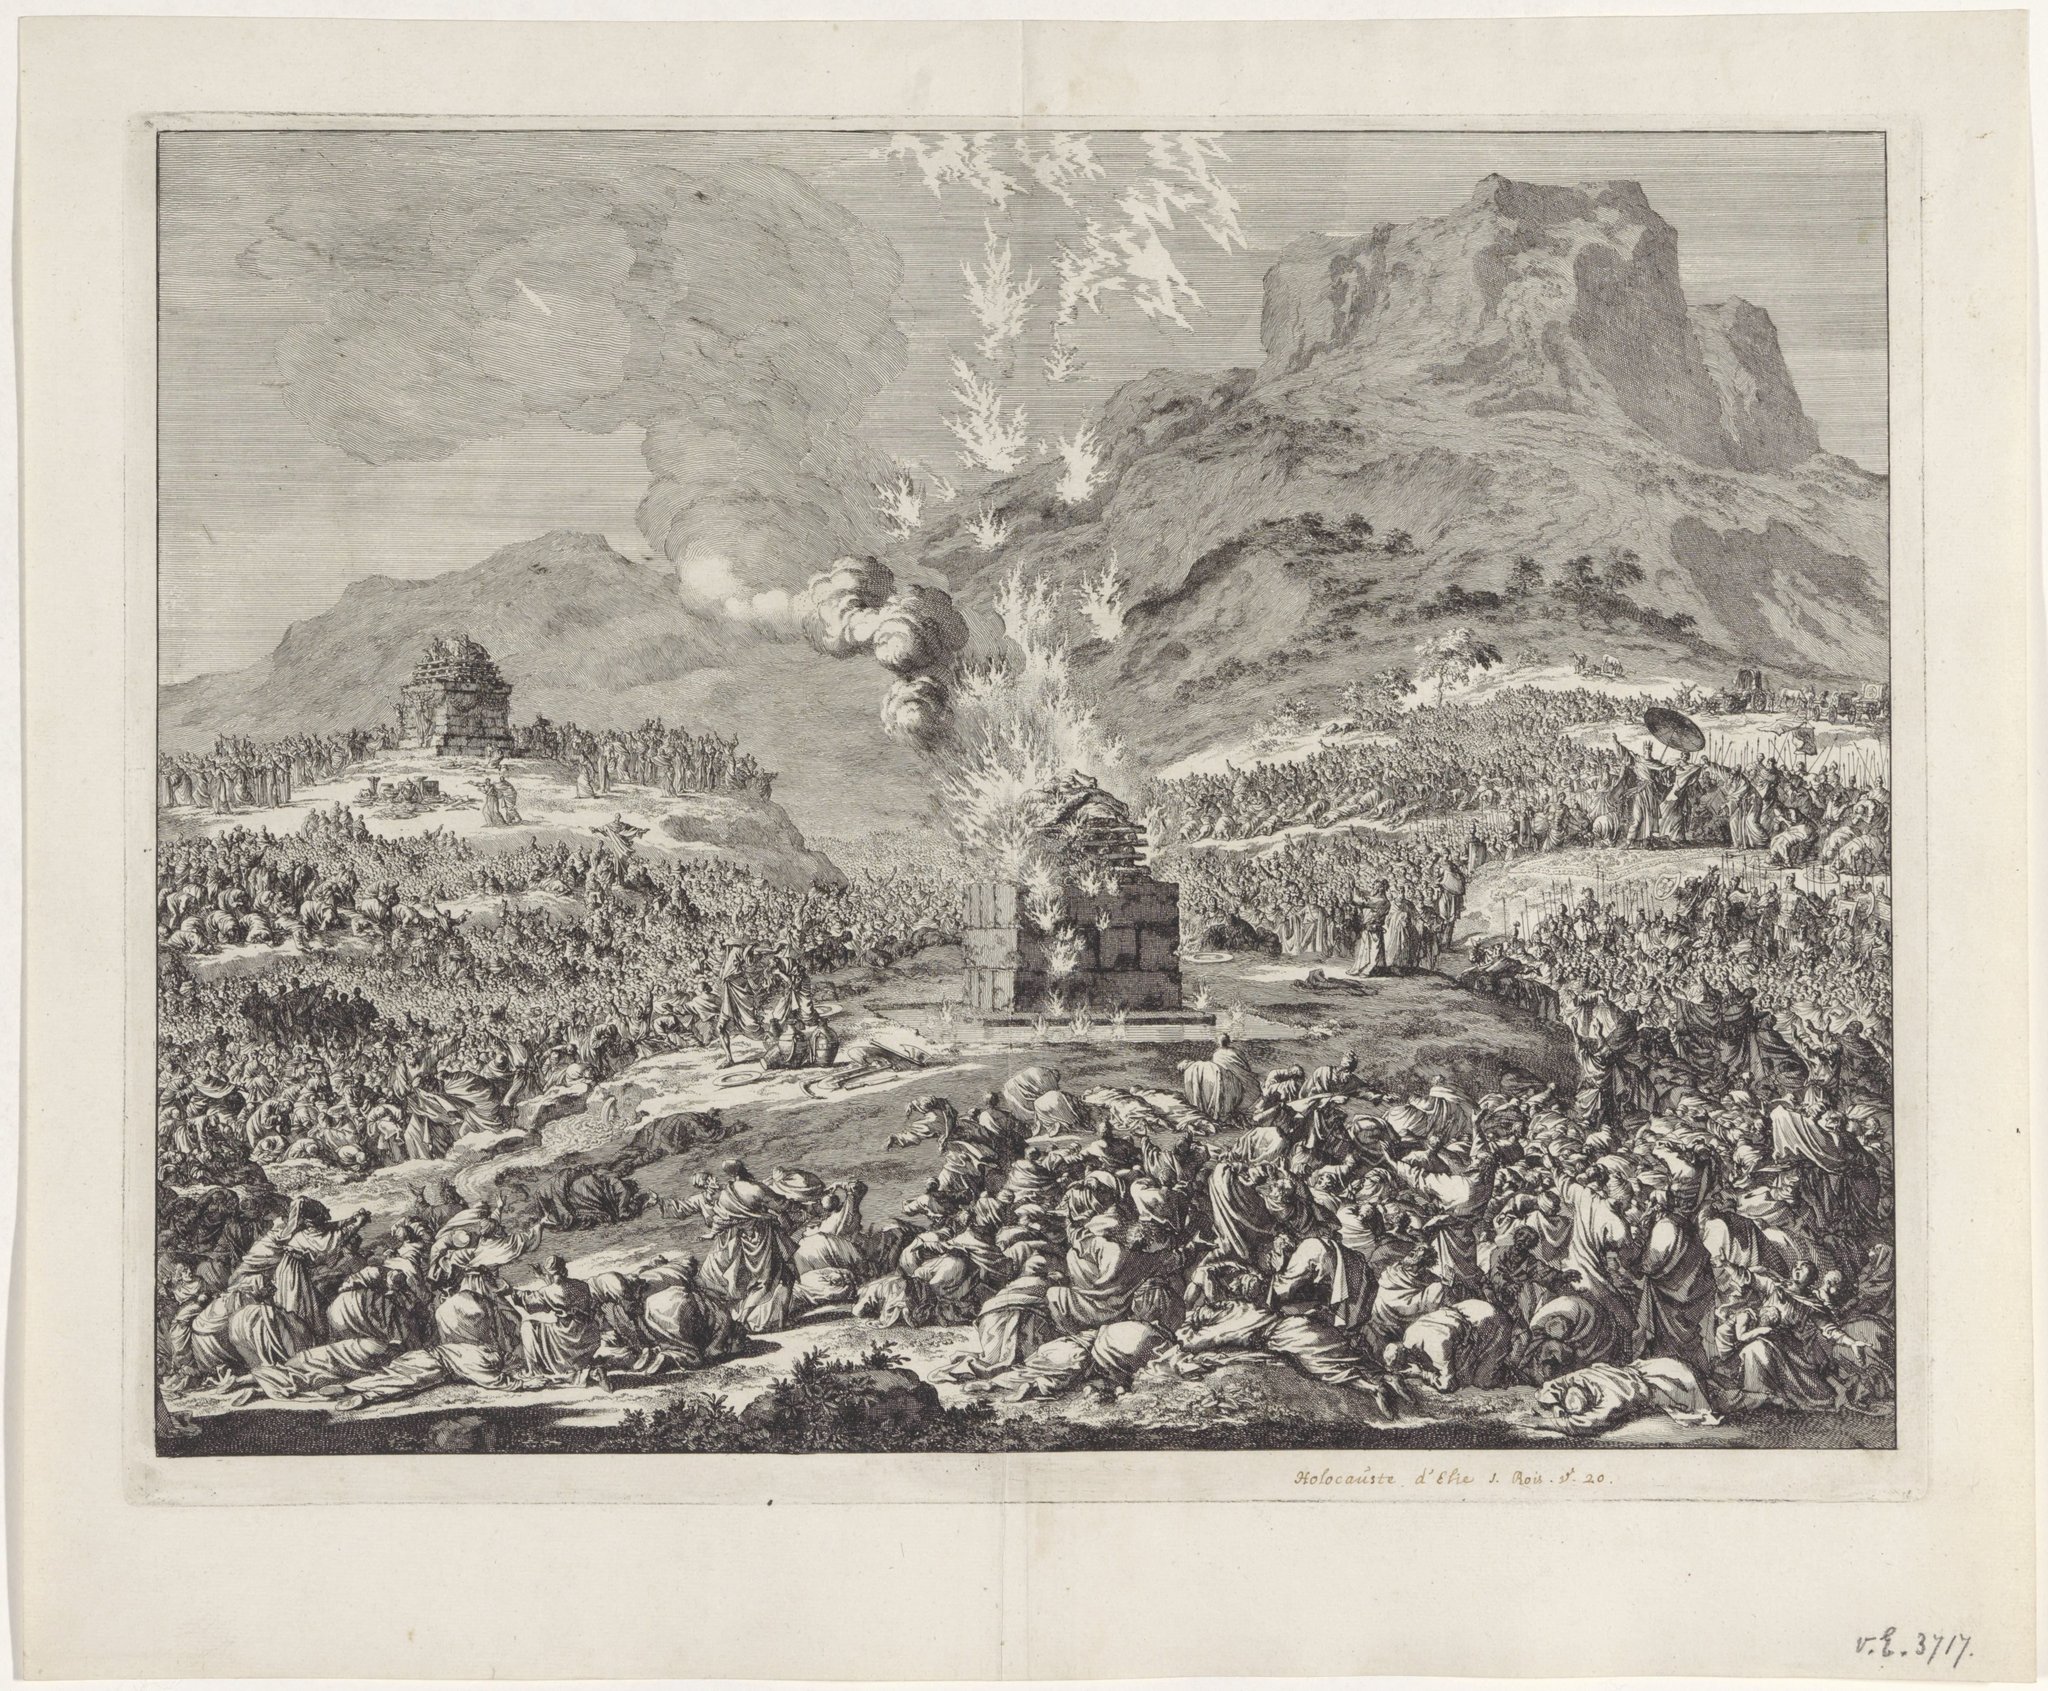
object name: print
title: Elias Offerhande door 't Vuur van de Hemel verteert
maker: jan luyken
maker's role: draughtsman, print maker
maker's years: 1649-1712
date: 1708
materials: paper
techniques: etching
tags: ahab is reproved by elijah and asked to gather the priests of baal on mount carmel for a contest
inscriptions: collector's mark: Lugt 2228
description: Het altaar met het offer van Elia wordt door God ontstoken als teken van zijn macht. Links staan de Baälpriesters die tevergeefs hebben geprobeerd hun offer te laten branden. Rechts knielt Elia terwijl hij God aanroept.